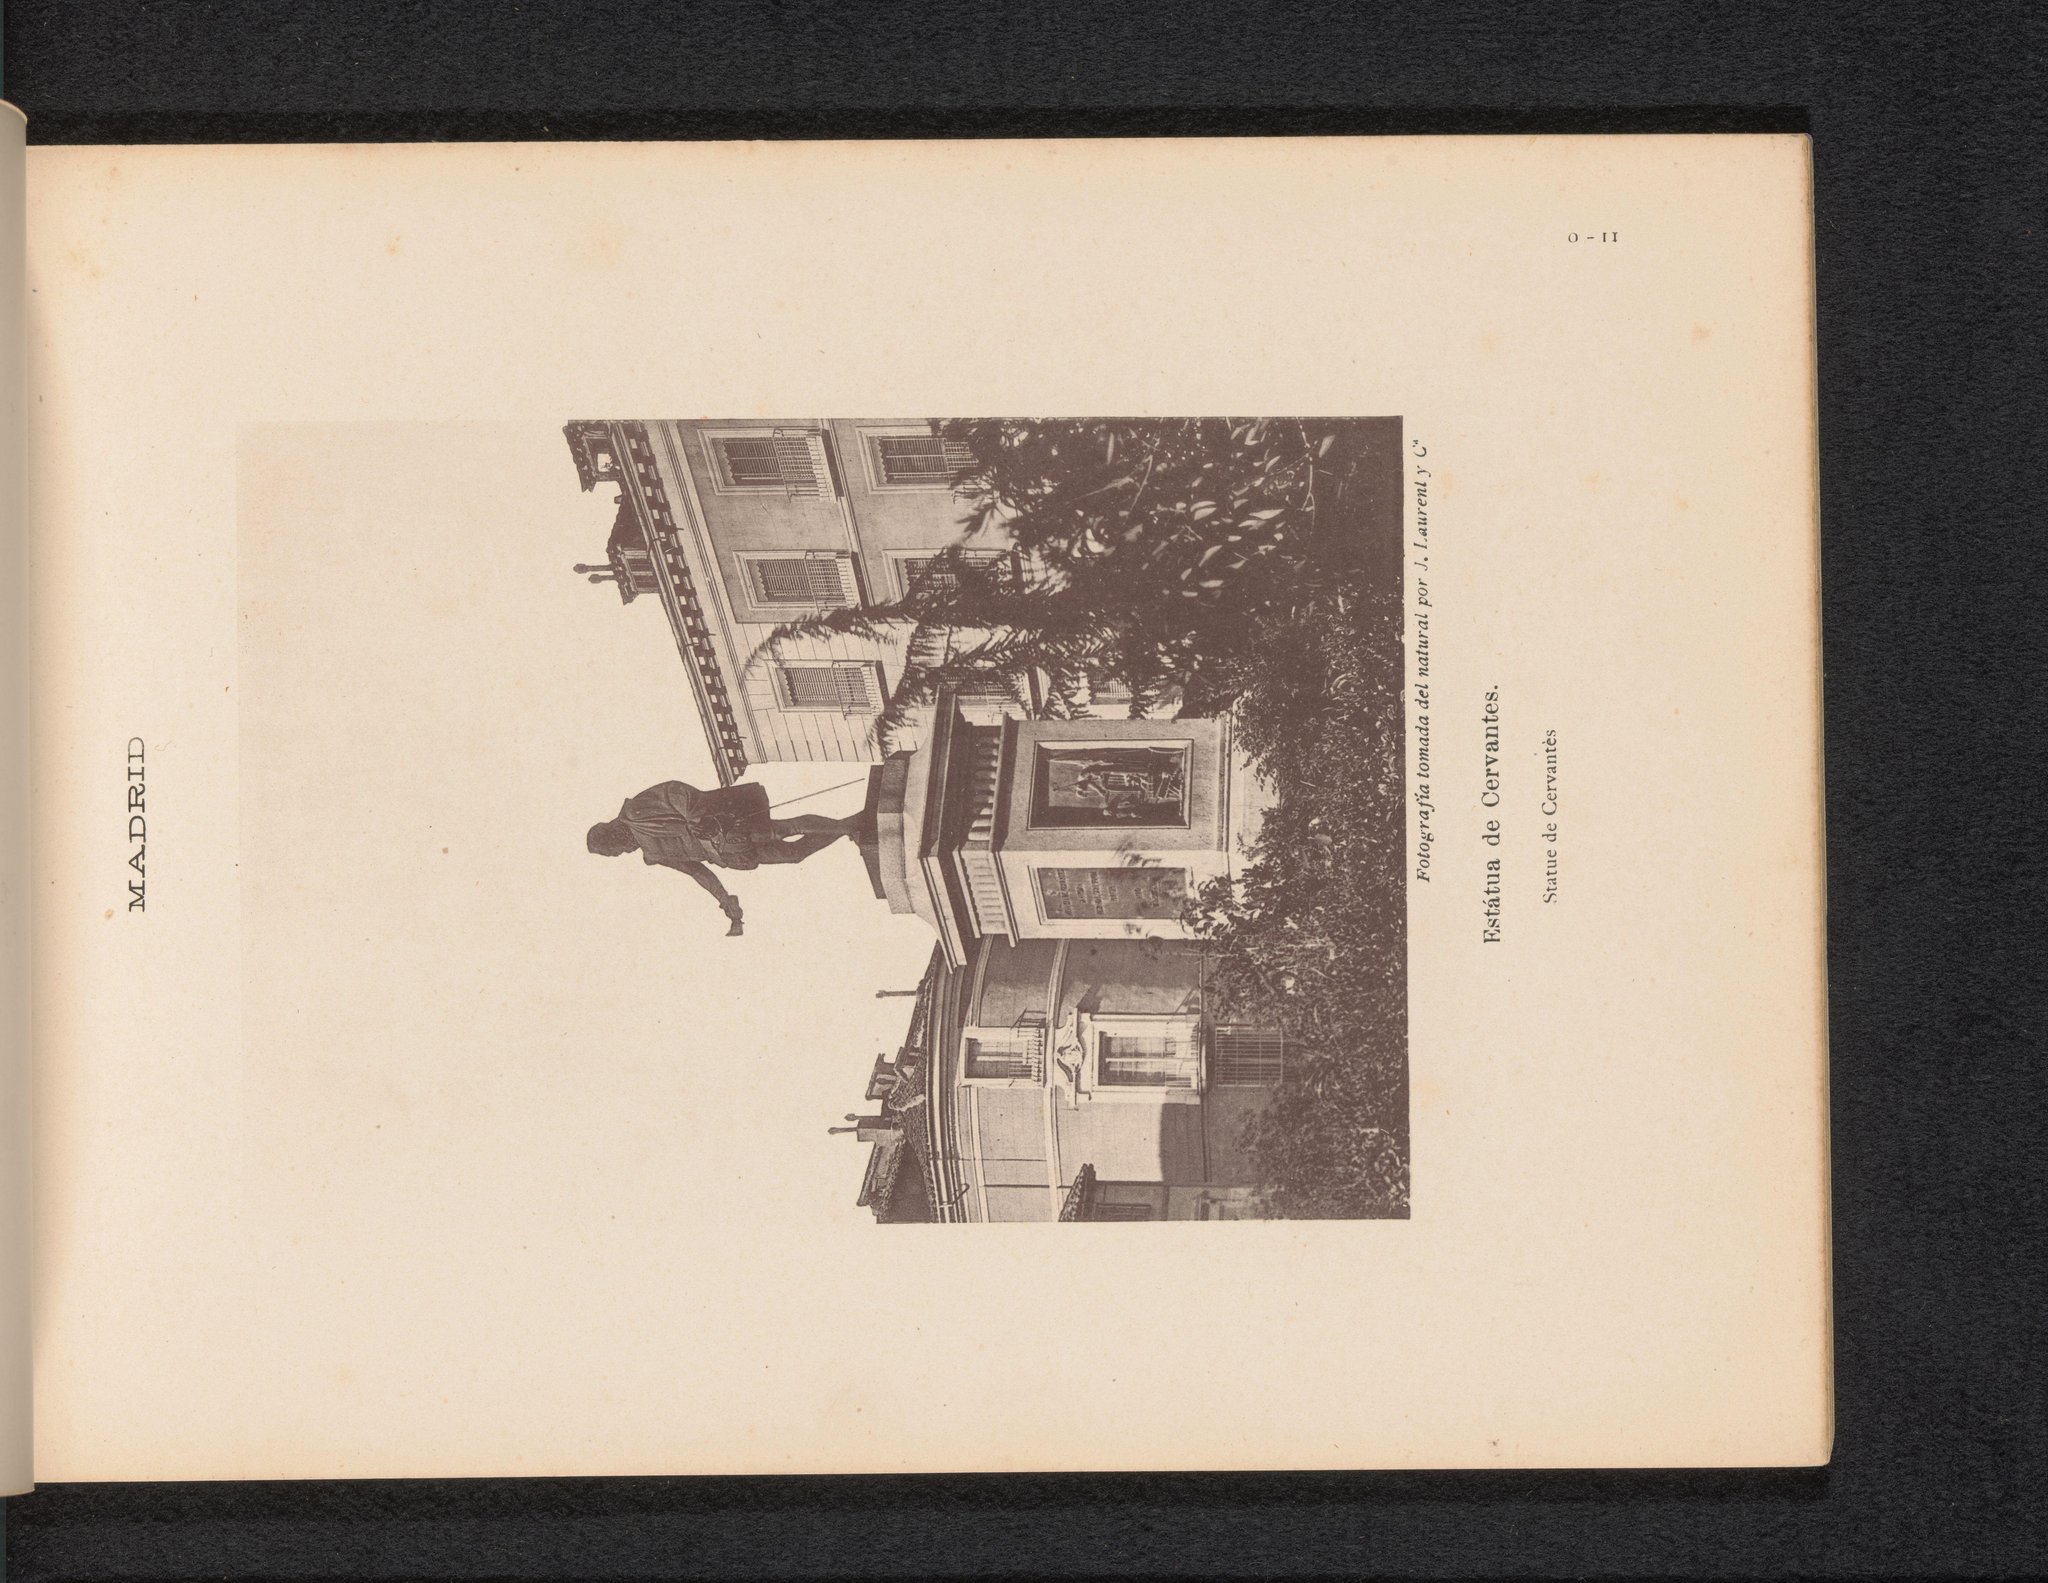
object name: photomechanical print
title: Madrid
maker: juan laurent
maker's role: publisher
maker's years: 1816-1896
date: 1880-1890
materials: paper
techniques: photograph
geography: plaza de las cortes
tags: monument, statue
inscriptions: number: ‘0-11’